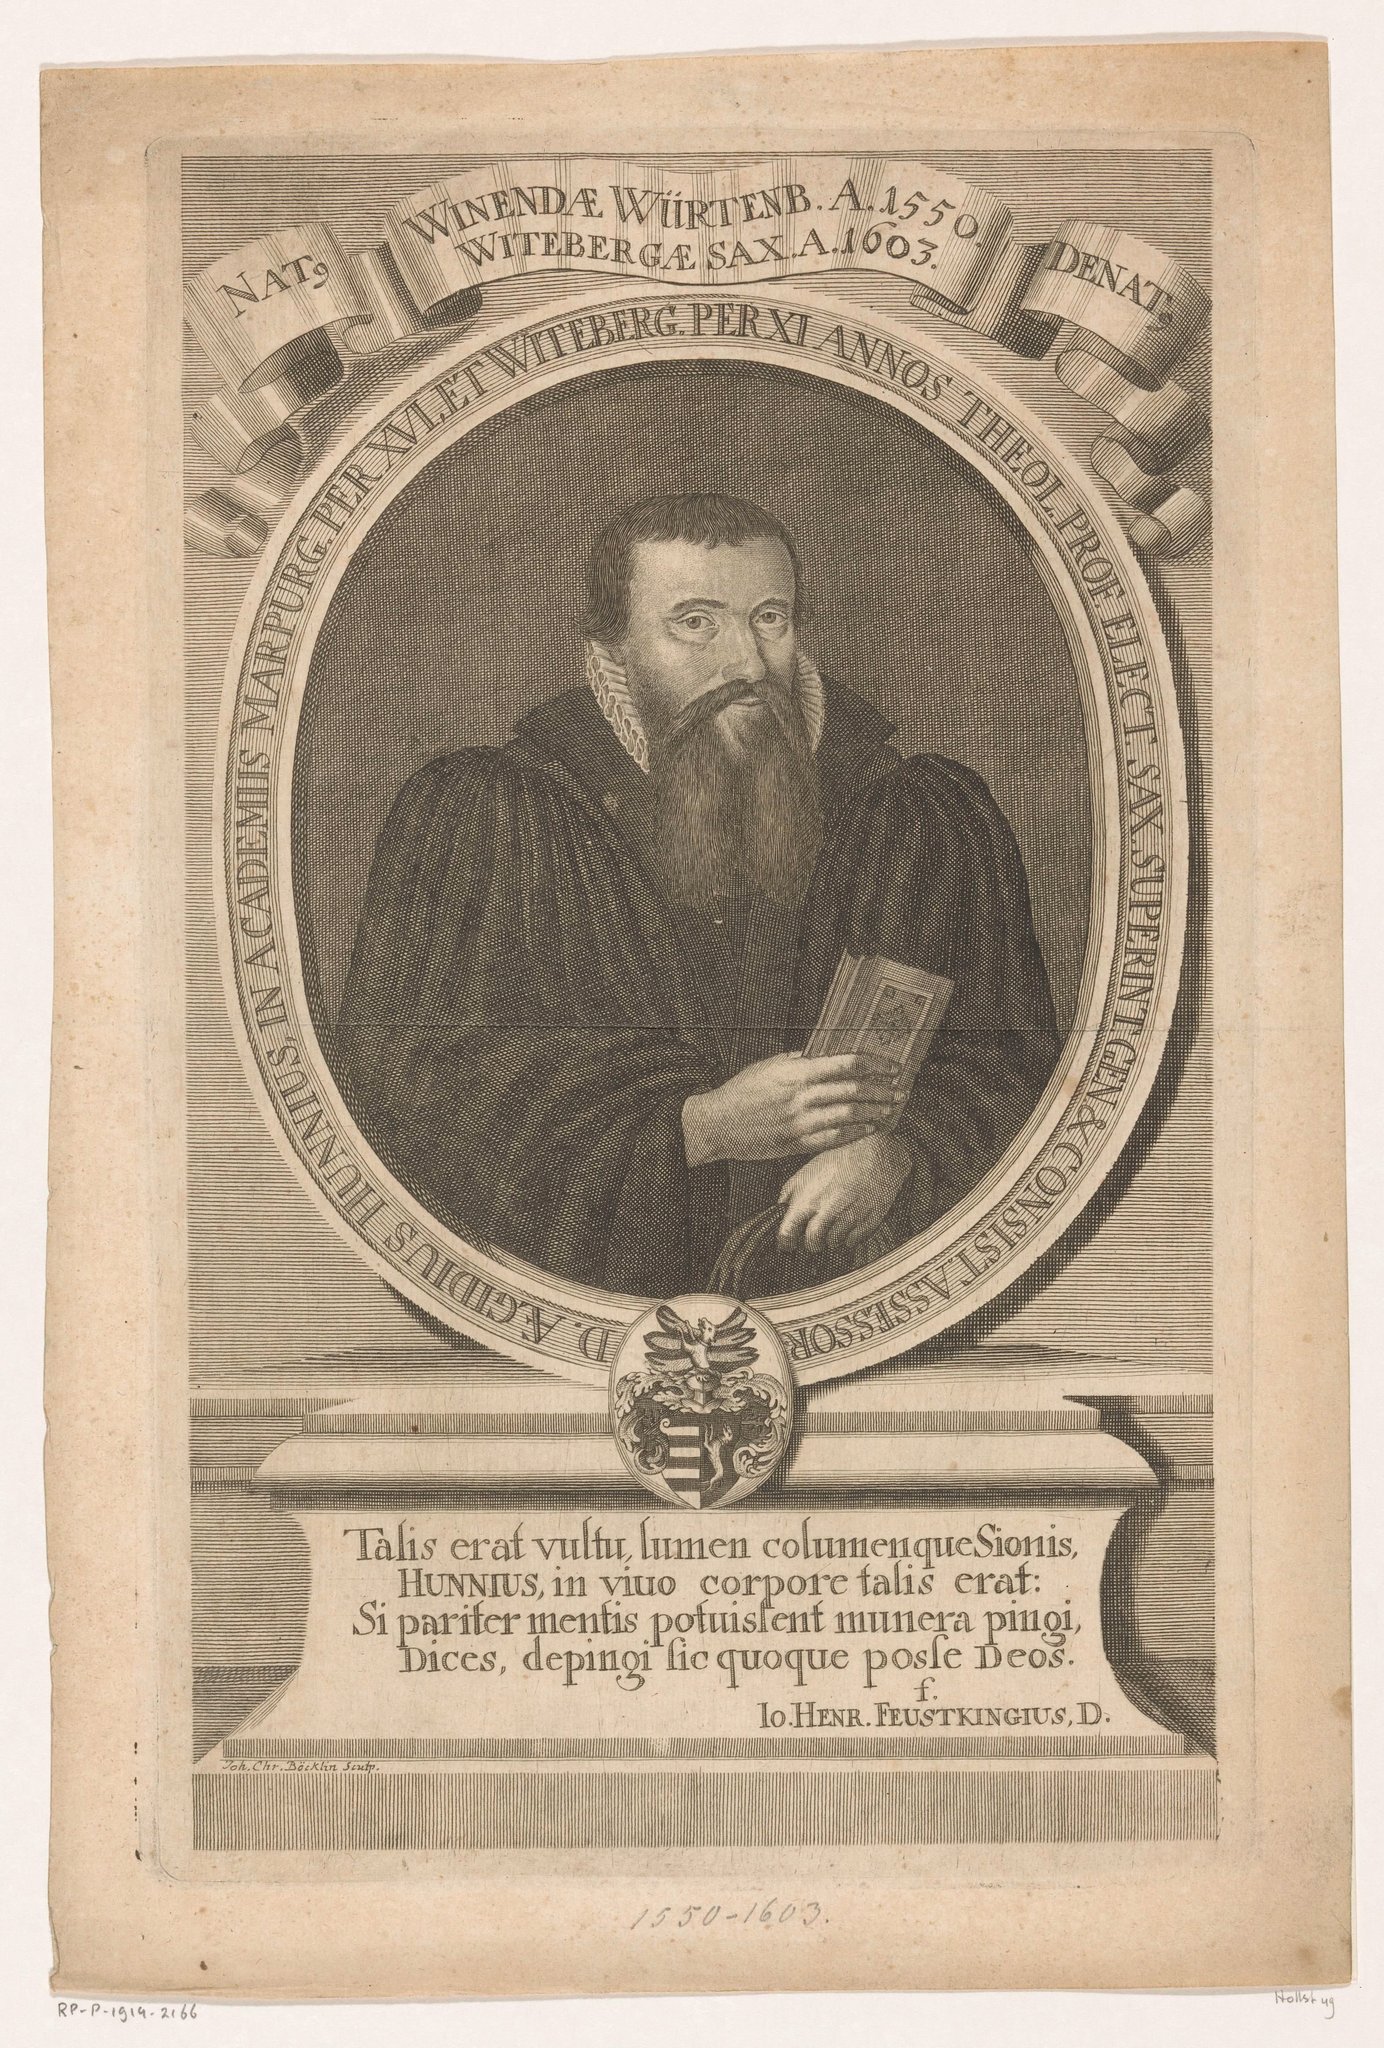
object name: print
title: Portret van Aegidius Hunnius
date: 1682-1709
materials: paper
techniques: engraving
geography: leipzig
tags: historical persons, book, armorial bearing, heraldry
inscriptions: collector's mark: Lugt 2228